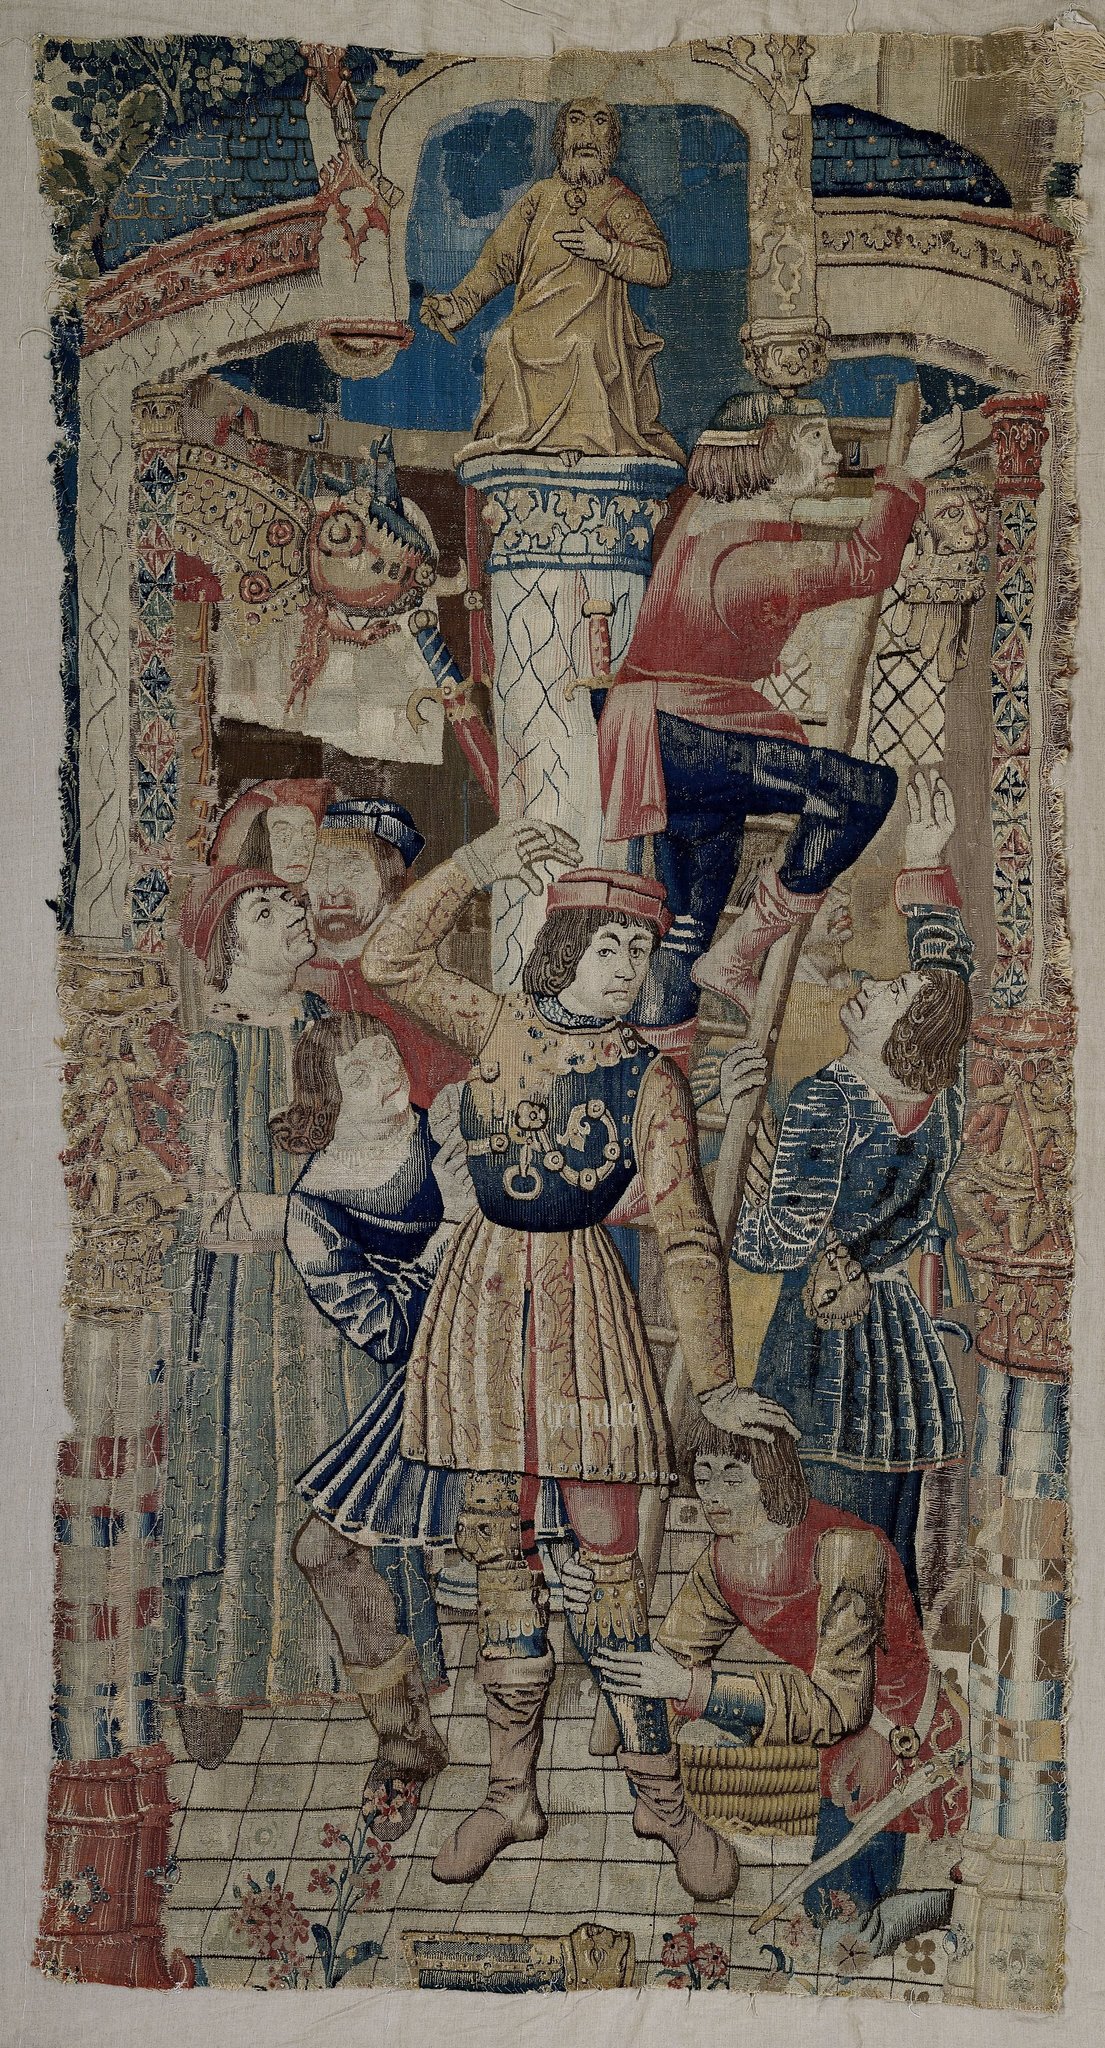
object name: tapestry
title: Hercules bewapent zich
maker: Anonymous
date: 1485-1505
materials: silk, wool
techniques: tapestry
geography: southern netherlands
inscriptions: : ‘HERCULES’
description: Tapestry (fragment). Hercules girds himself for the fight. Tournai or Brussels, c. 1485 - 1550.